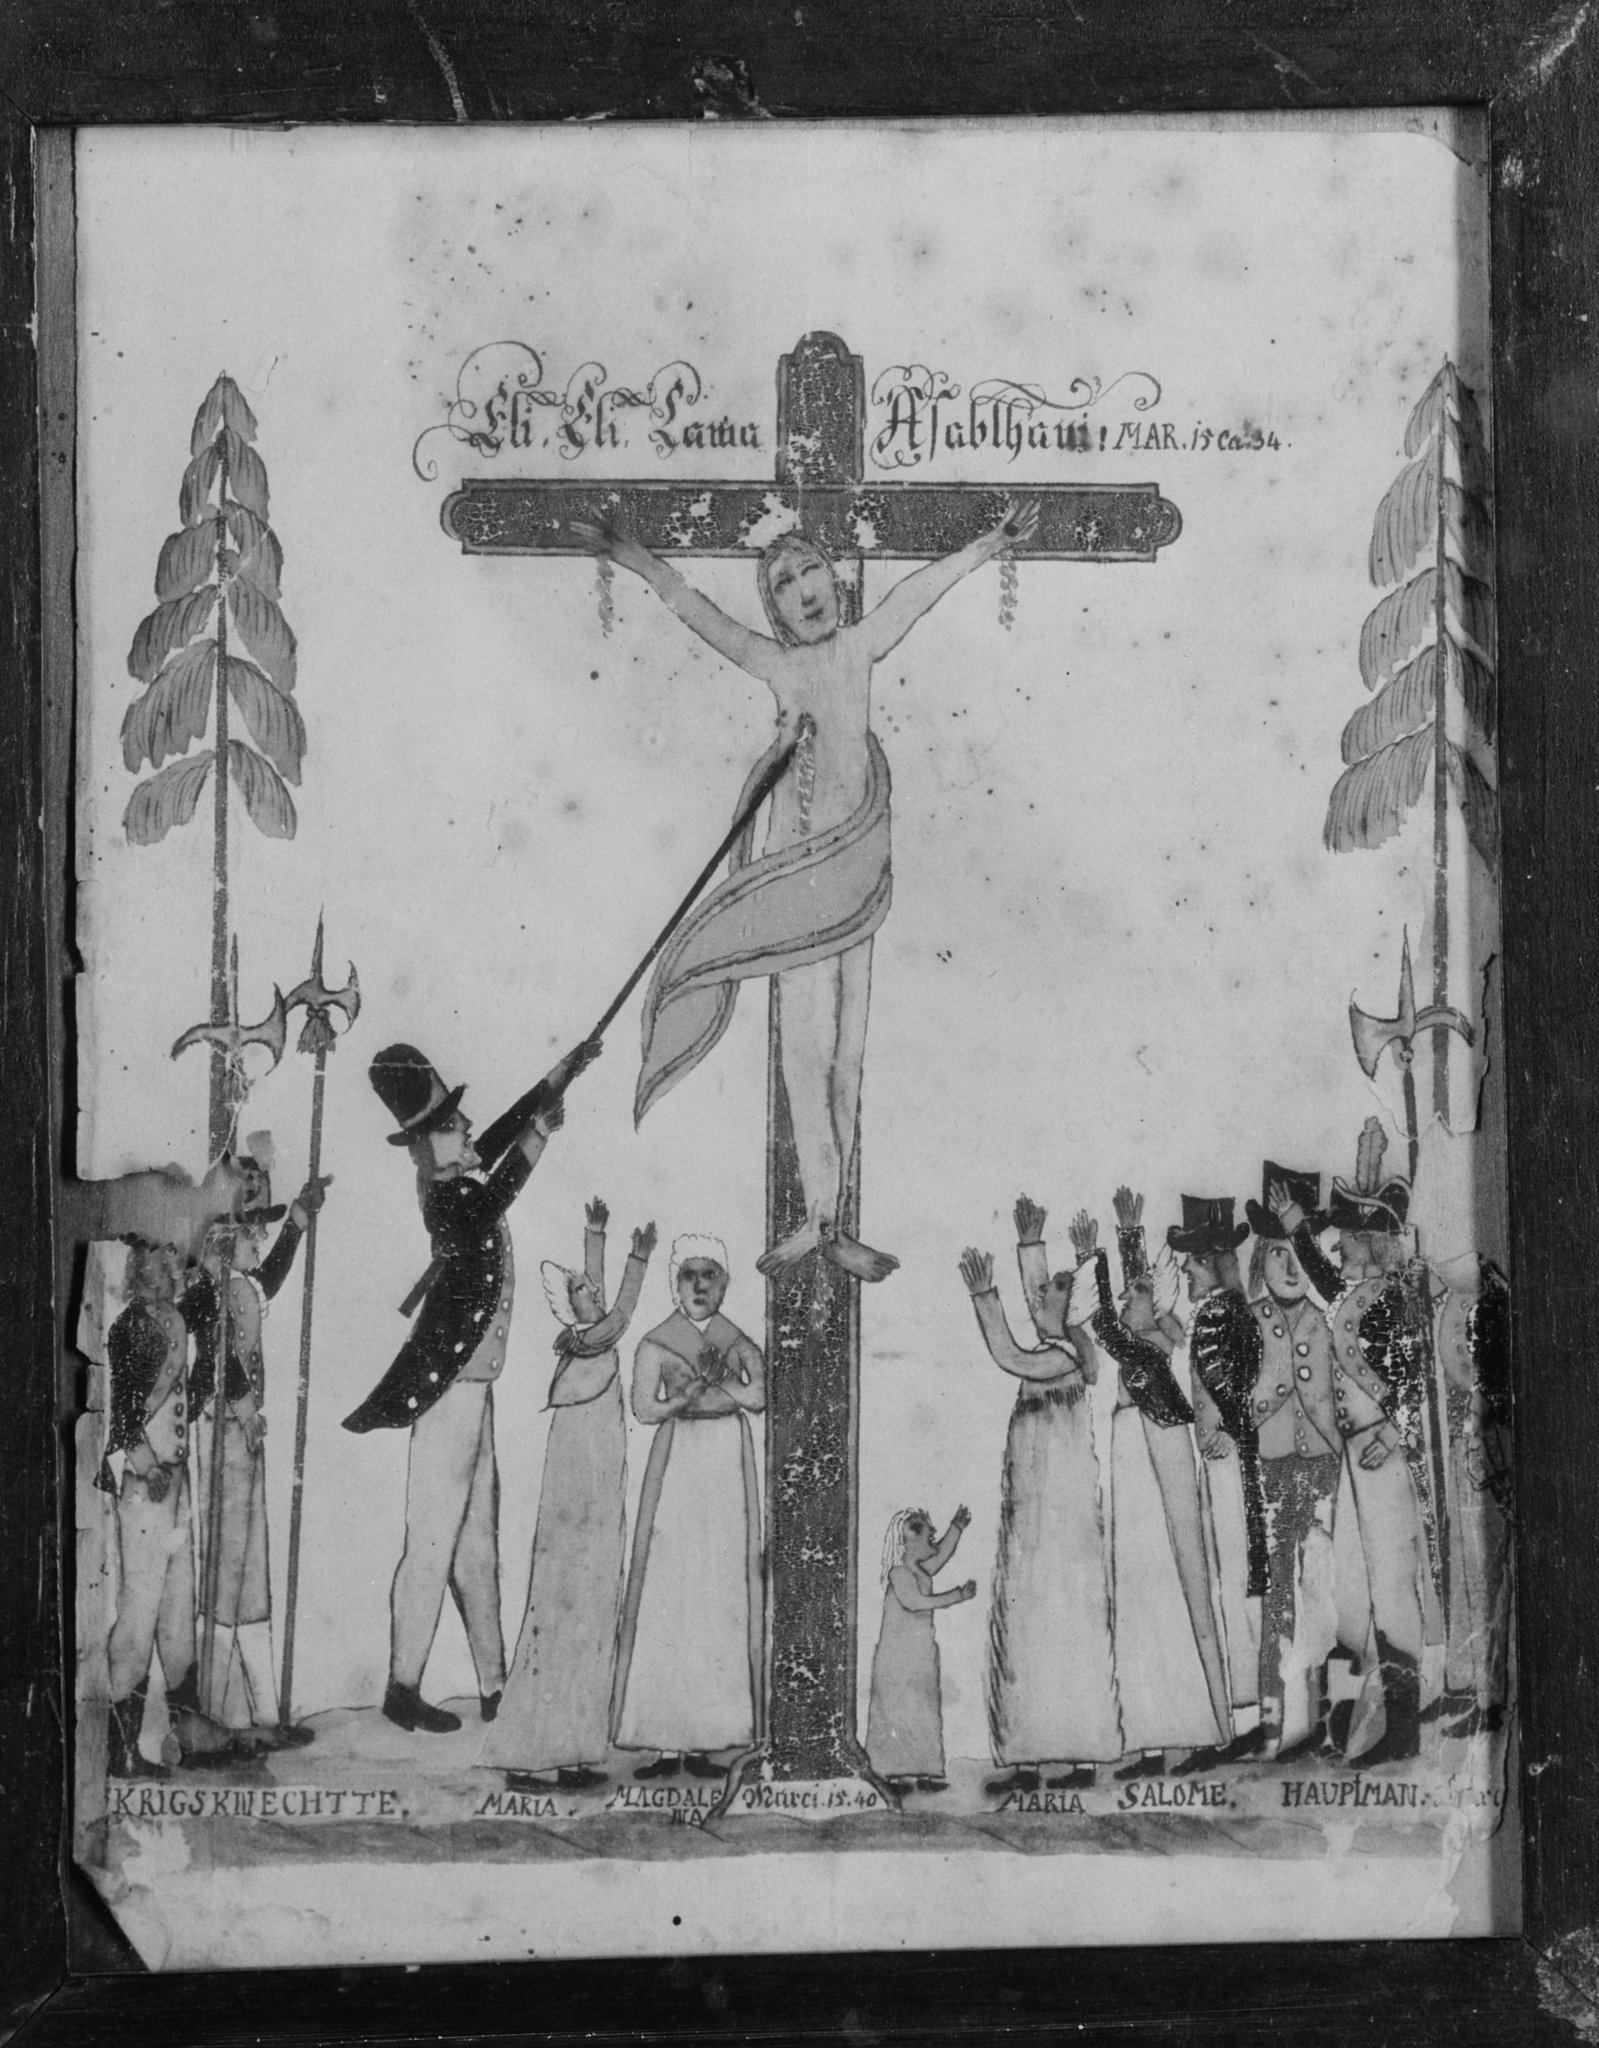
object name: drawing, fraktur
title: Drawing of the Crucifixion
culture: american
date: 1800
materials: paper, watercolor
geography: united states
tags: soldiers,christ,cross,crucifixion